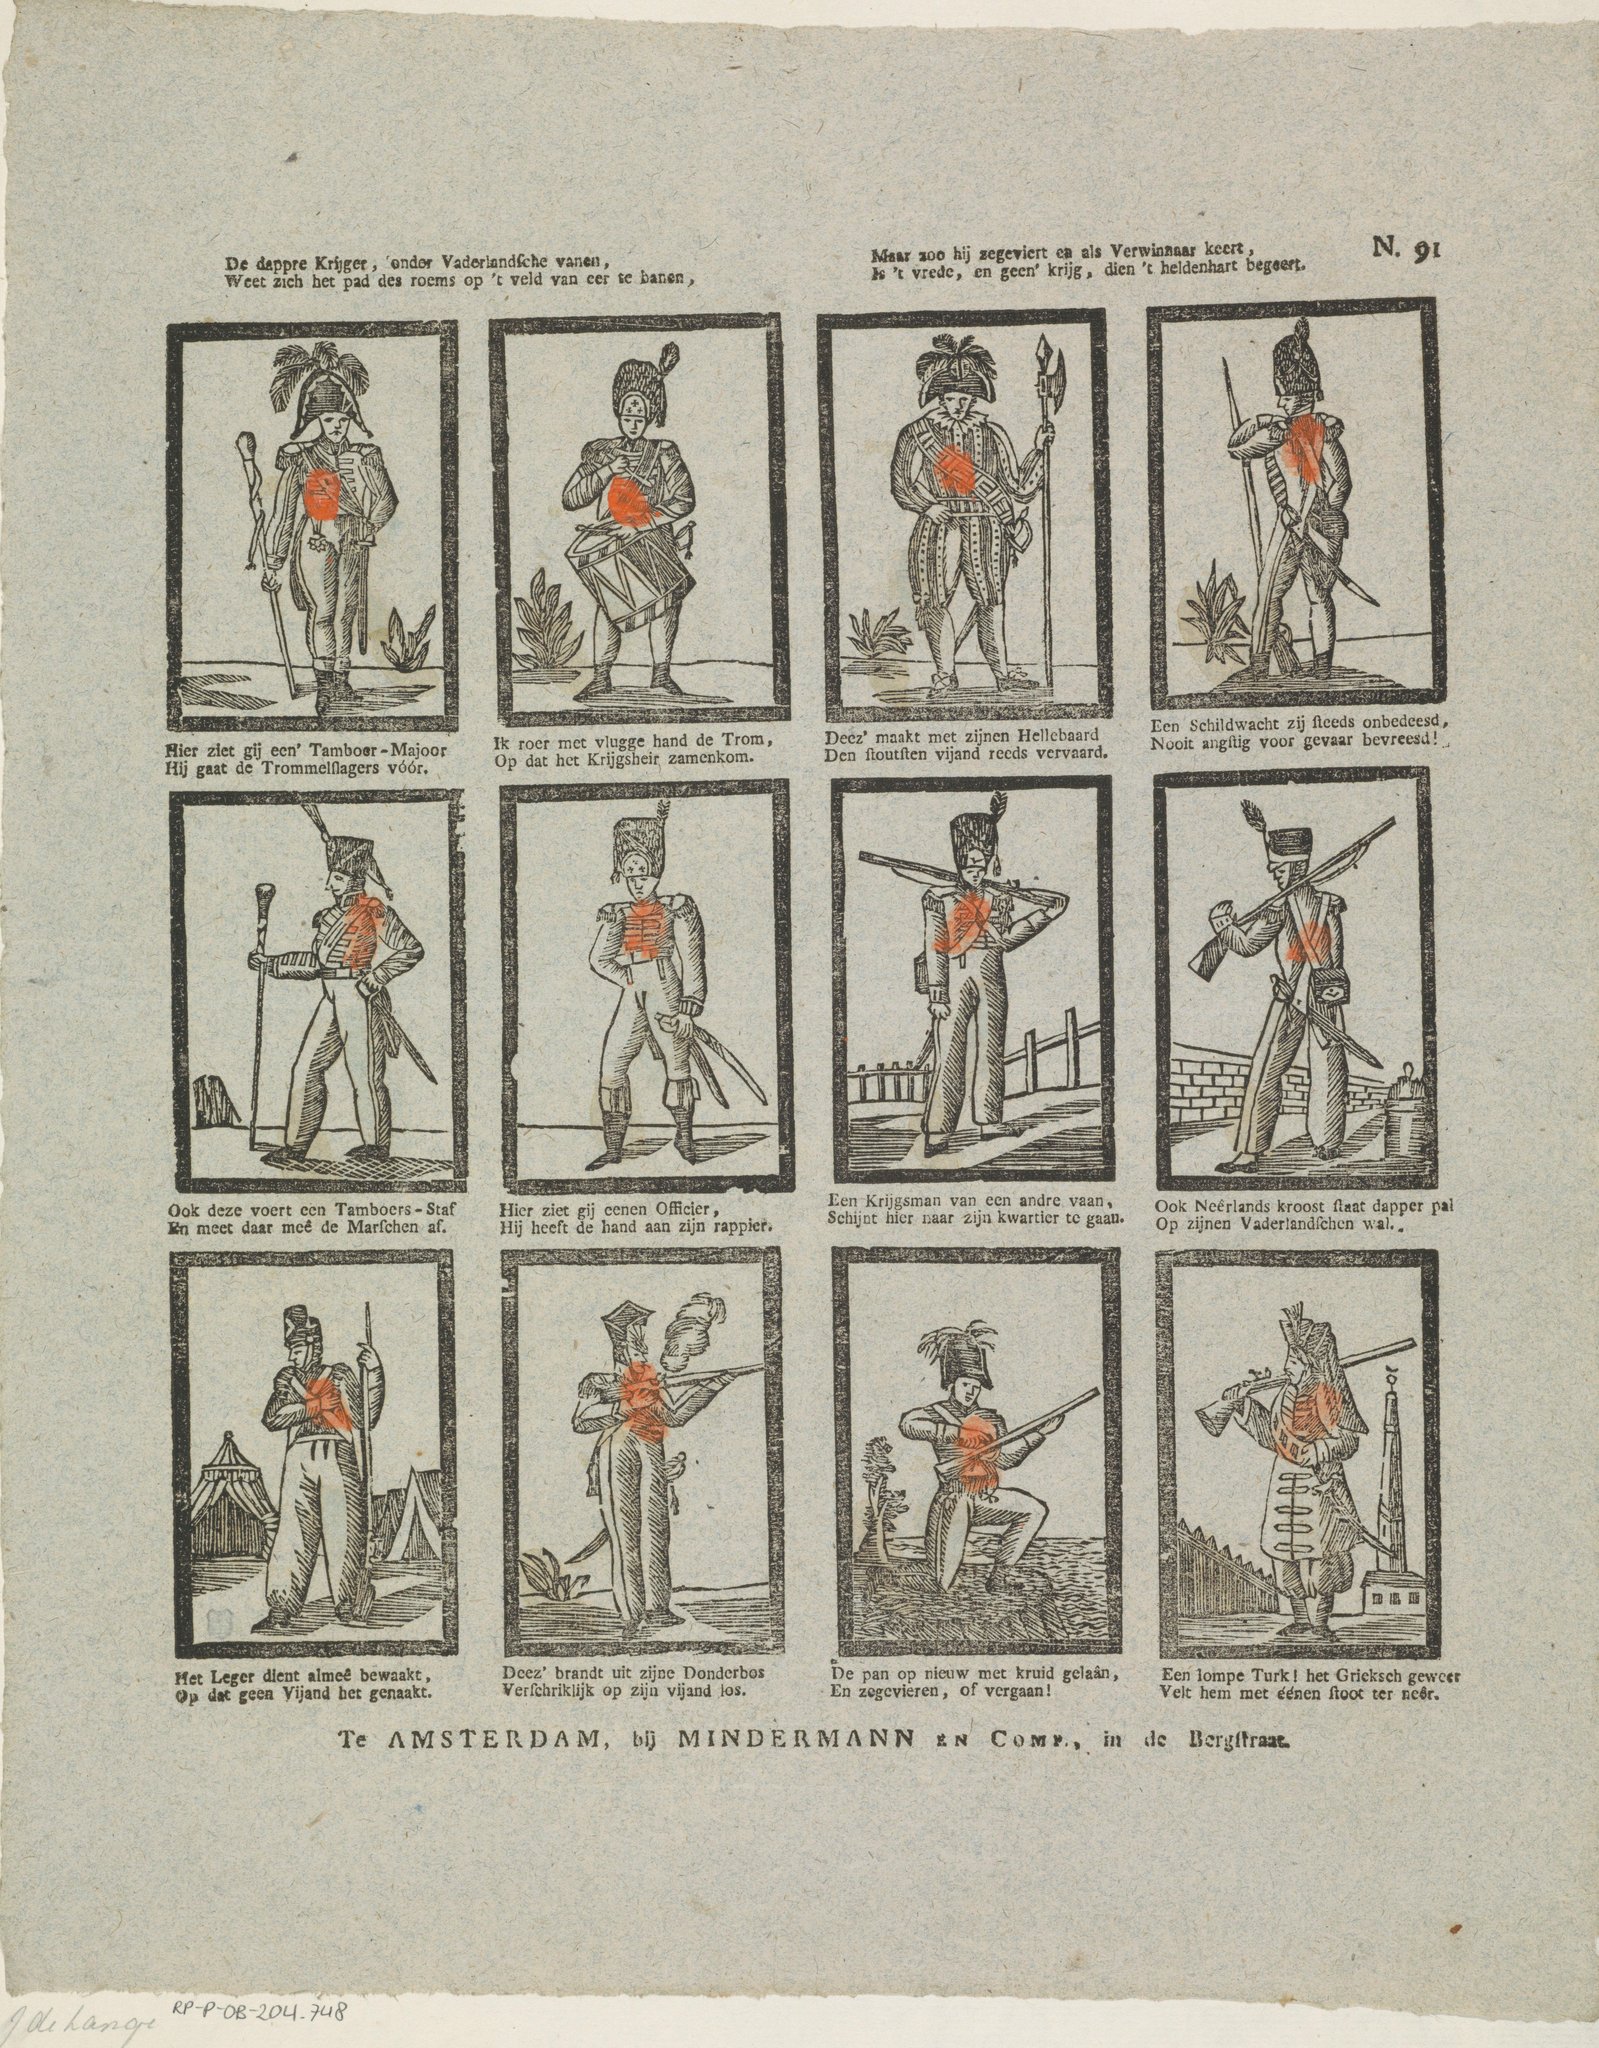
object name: popular print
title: De dappre krijger, onder vaderlandsche vanen, / Weet zich het pad des roems op 't veld van eer te banen, / Maar zoo hij zegeviert en als verwinnaar keert, / Is 't vrede, en geen' krijg, dien 't heldenhart begeert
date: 1822-1849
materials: paper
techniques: colour, letterpress printing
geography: netherlands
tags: the soldier; the soldier's life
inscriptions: collector's mark: Lugt 2760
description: Blad met 12 voorstellingen van militairen. Onder elke afbeelding een tweeregelig vers. Genummerd rechtsboven: N. 91.